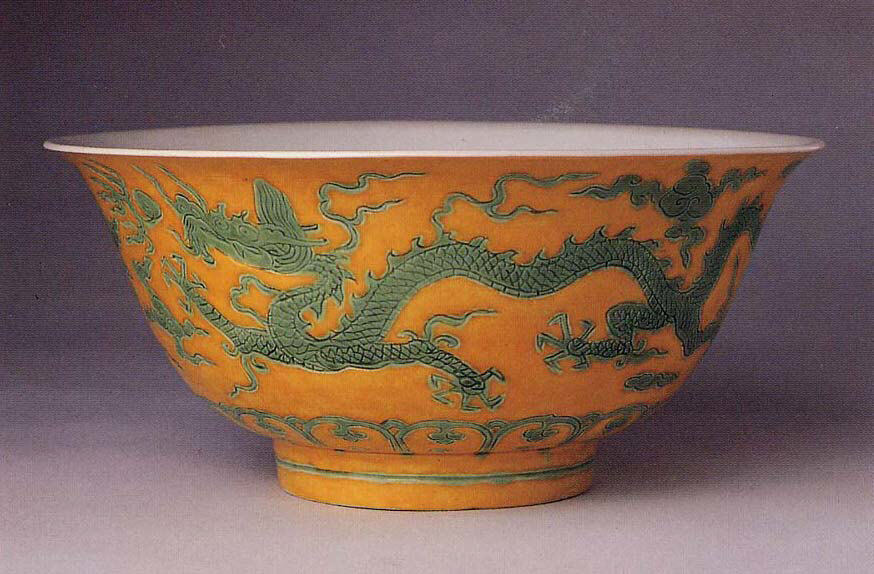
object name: bowl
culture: chinese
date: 1506-1521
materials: glaze, porcelain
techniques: incising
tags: dragons